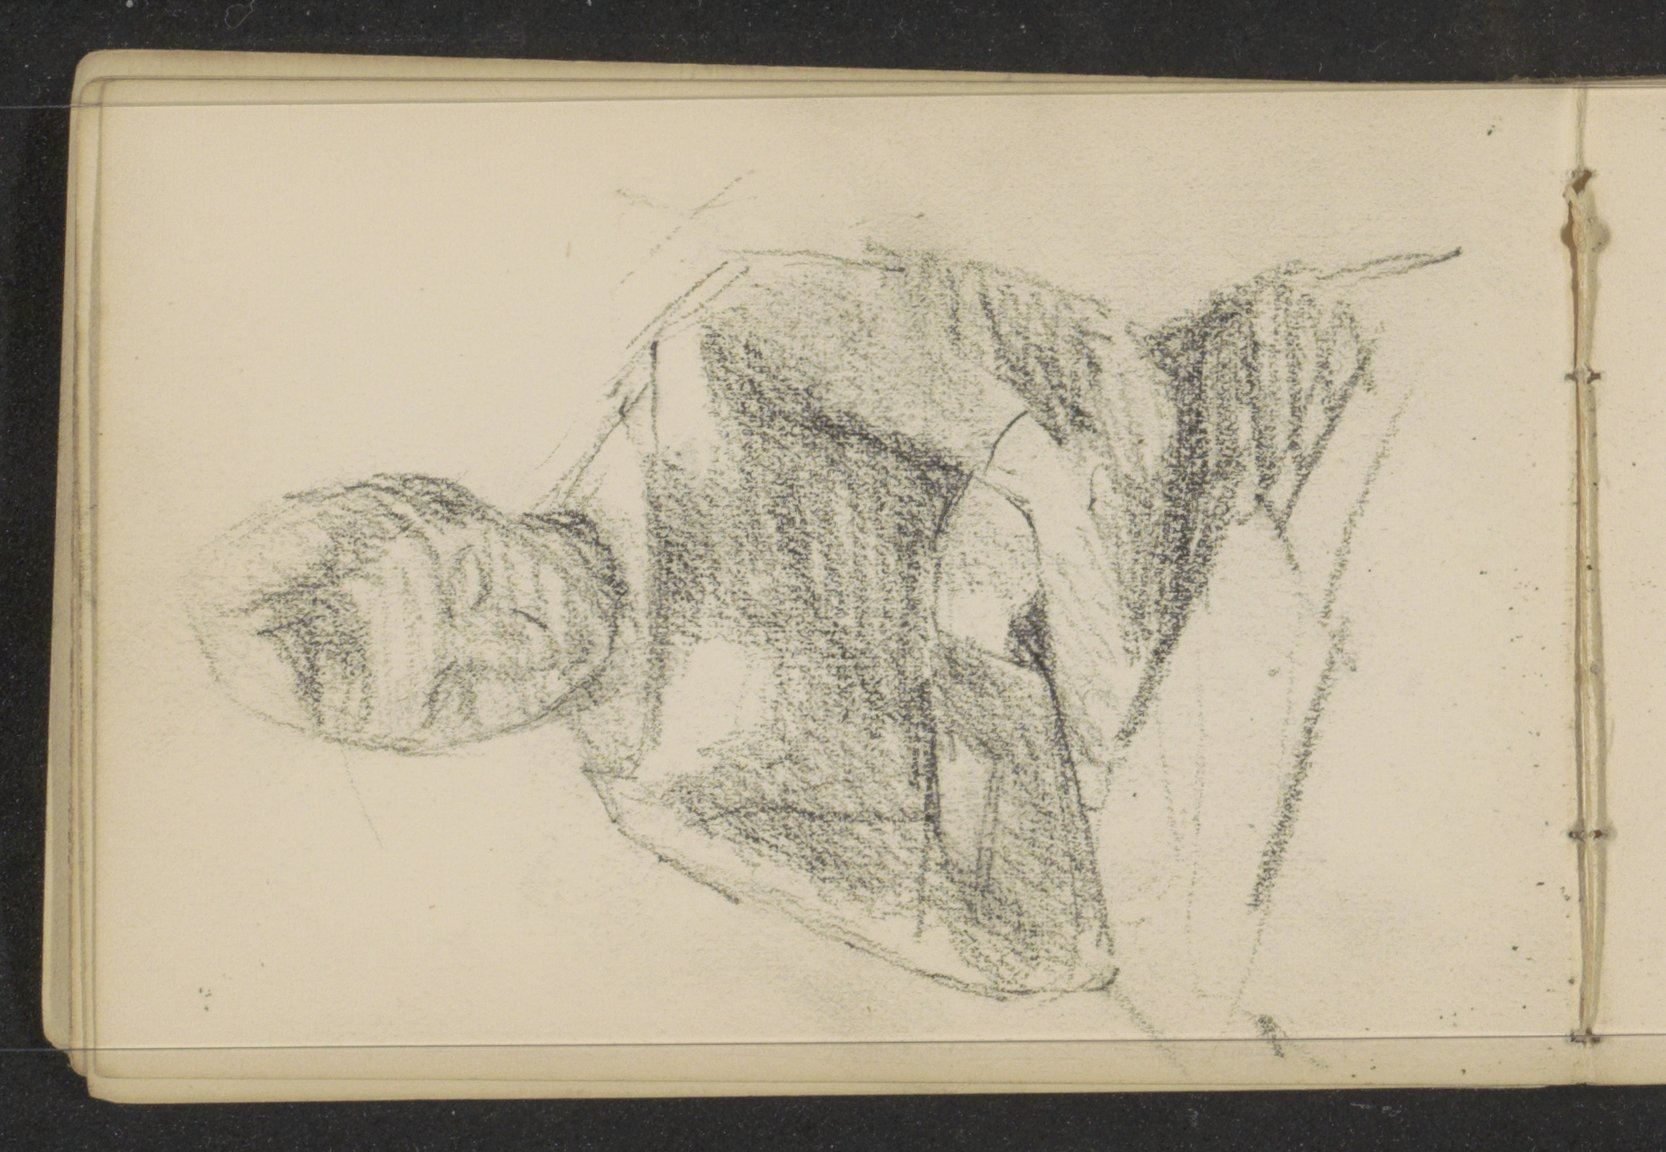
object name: sketchbook leaf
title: Lezende jonge vrouw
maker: Anonymous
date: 1880-1900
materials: paper, pencil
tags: arms crossed, reading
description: De vrouw zit met de armen over elkaar en heeft de ogen neergeslagen op een boek in haar schoot. Blad 9 verso uit een schetsboek met 29 bladen.